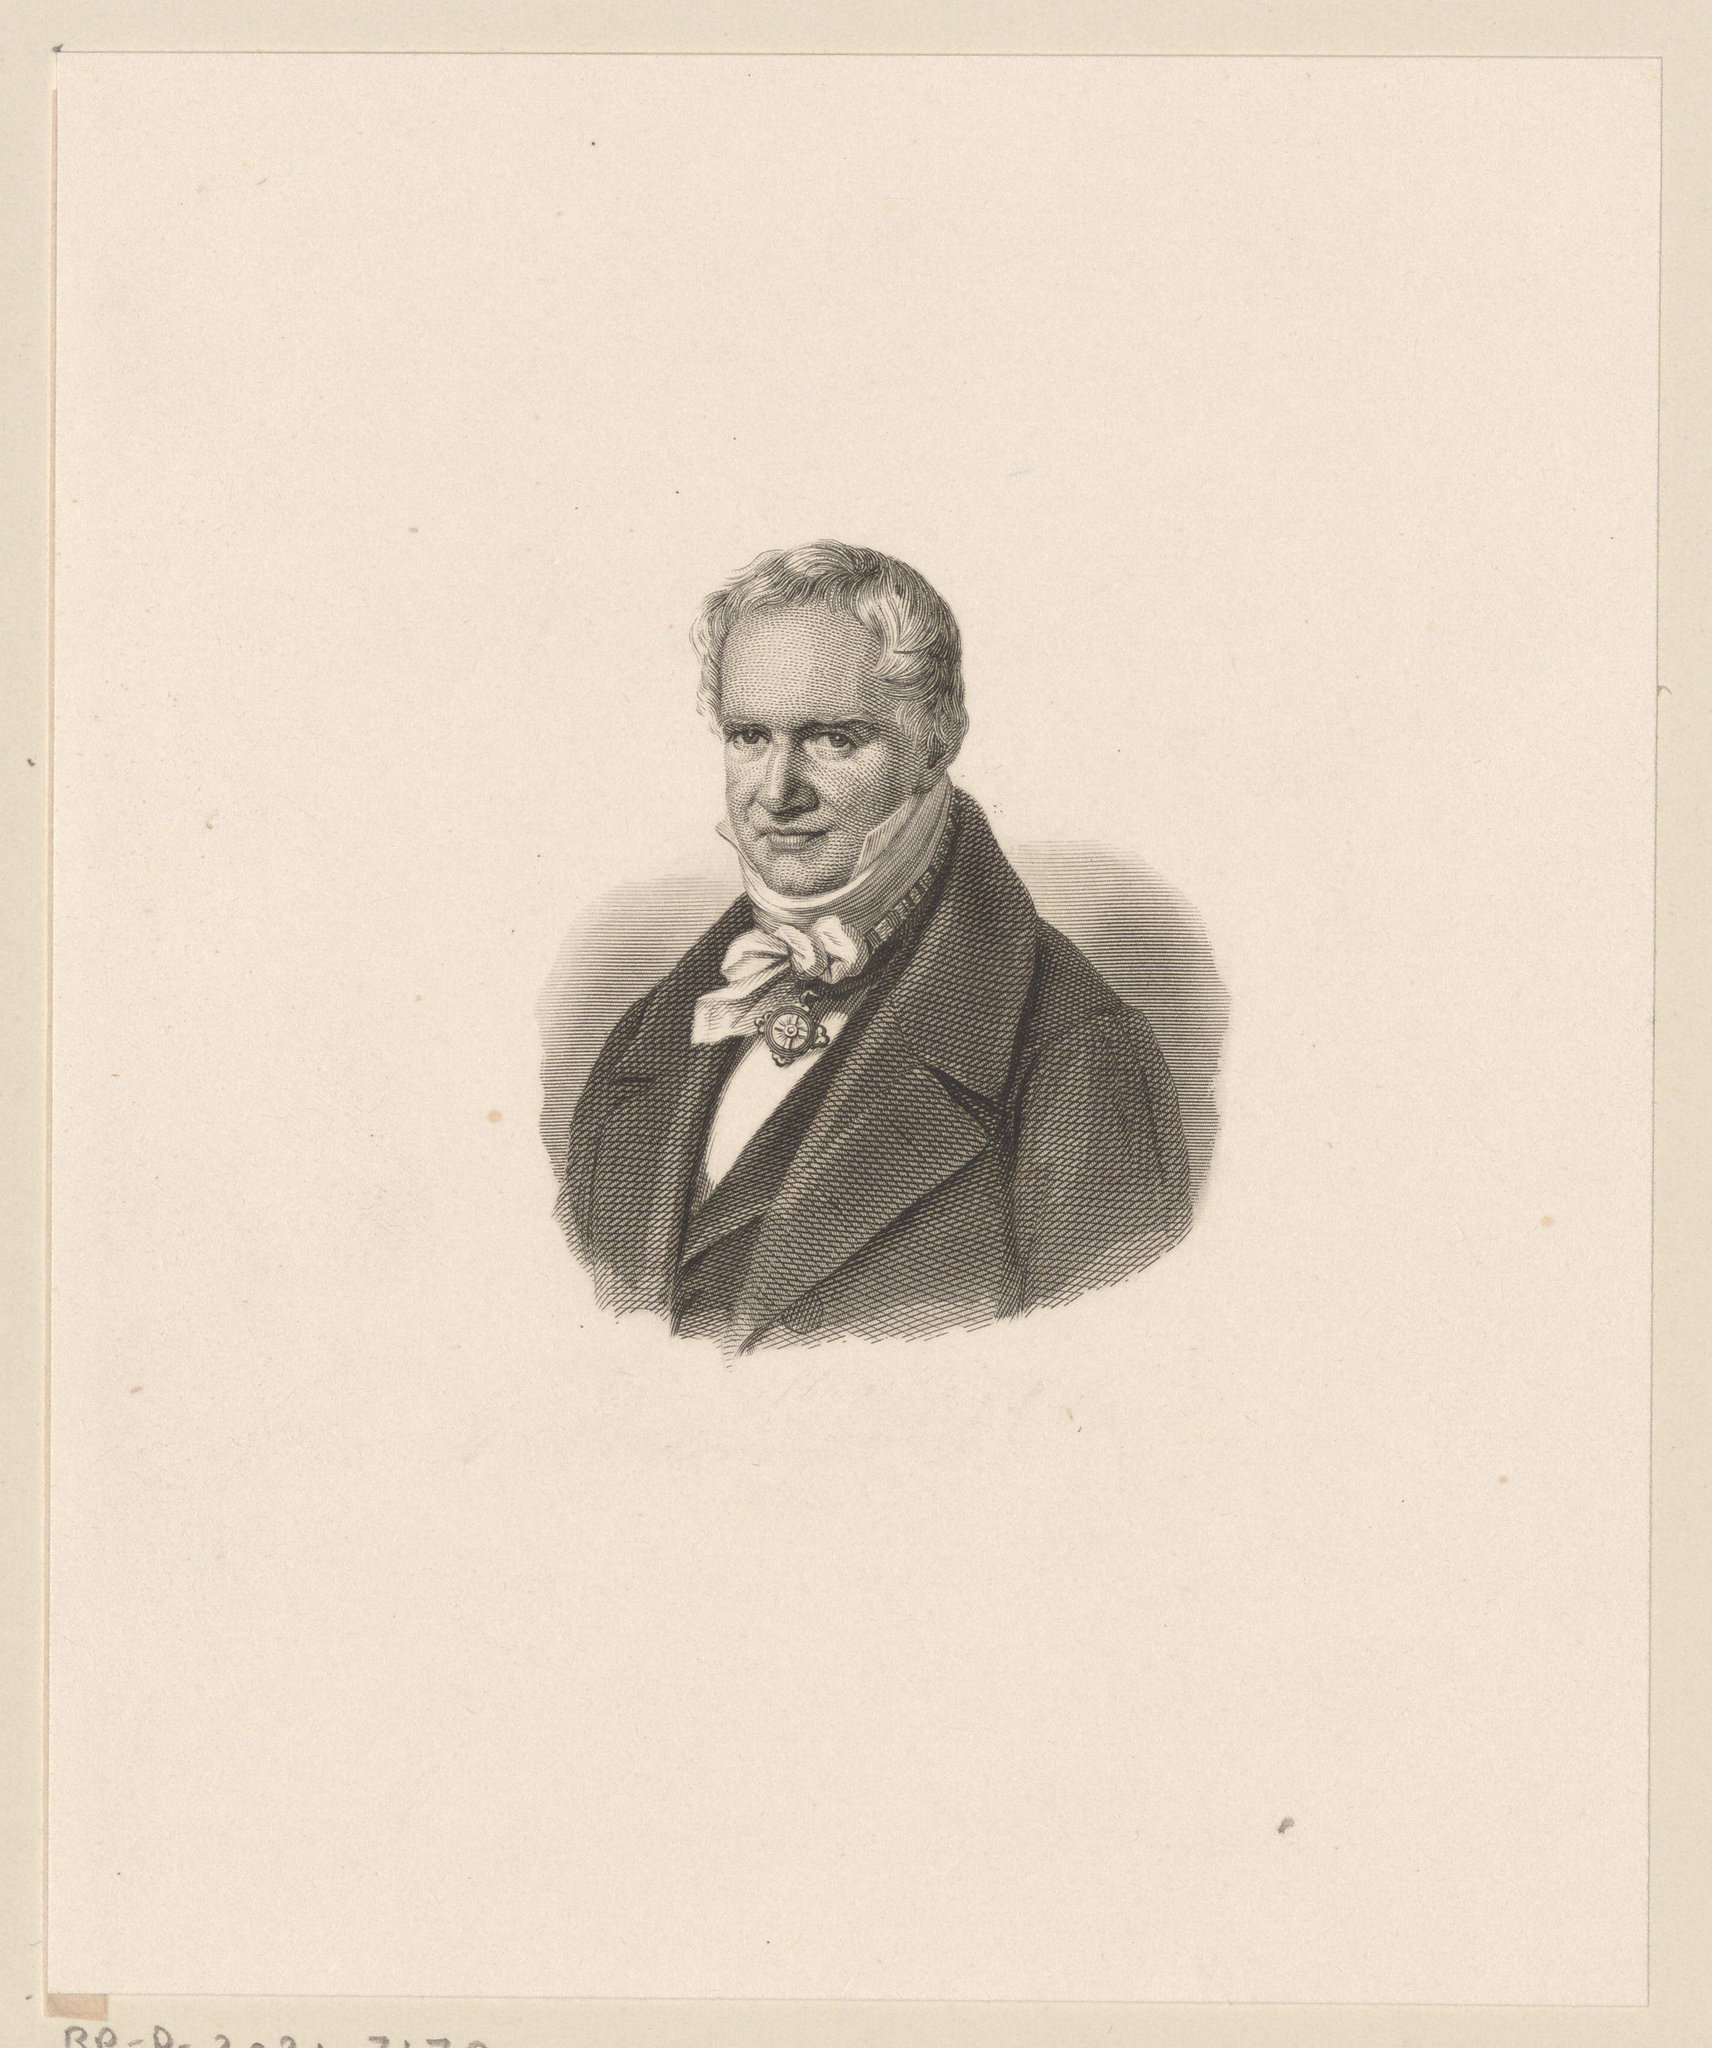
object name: print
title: Portret van Alexander von Humboldt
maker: Anonymous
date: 1800-1849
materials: paper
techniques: engraving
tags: berlin, traveler, historical persons, biology (+ portrait of scholar, scientist)